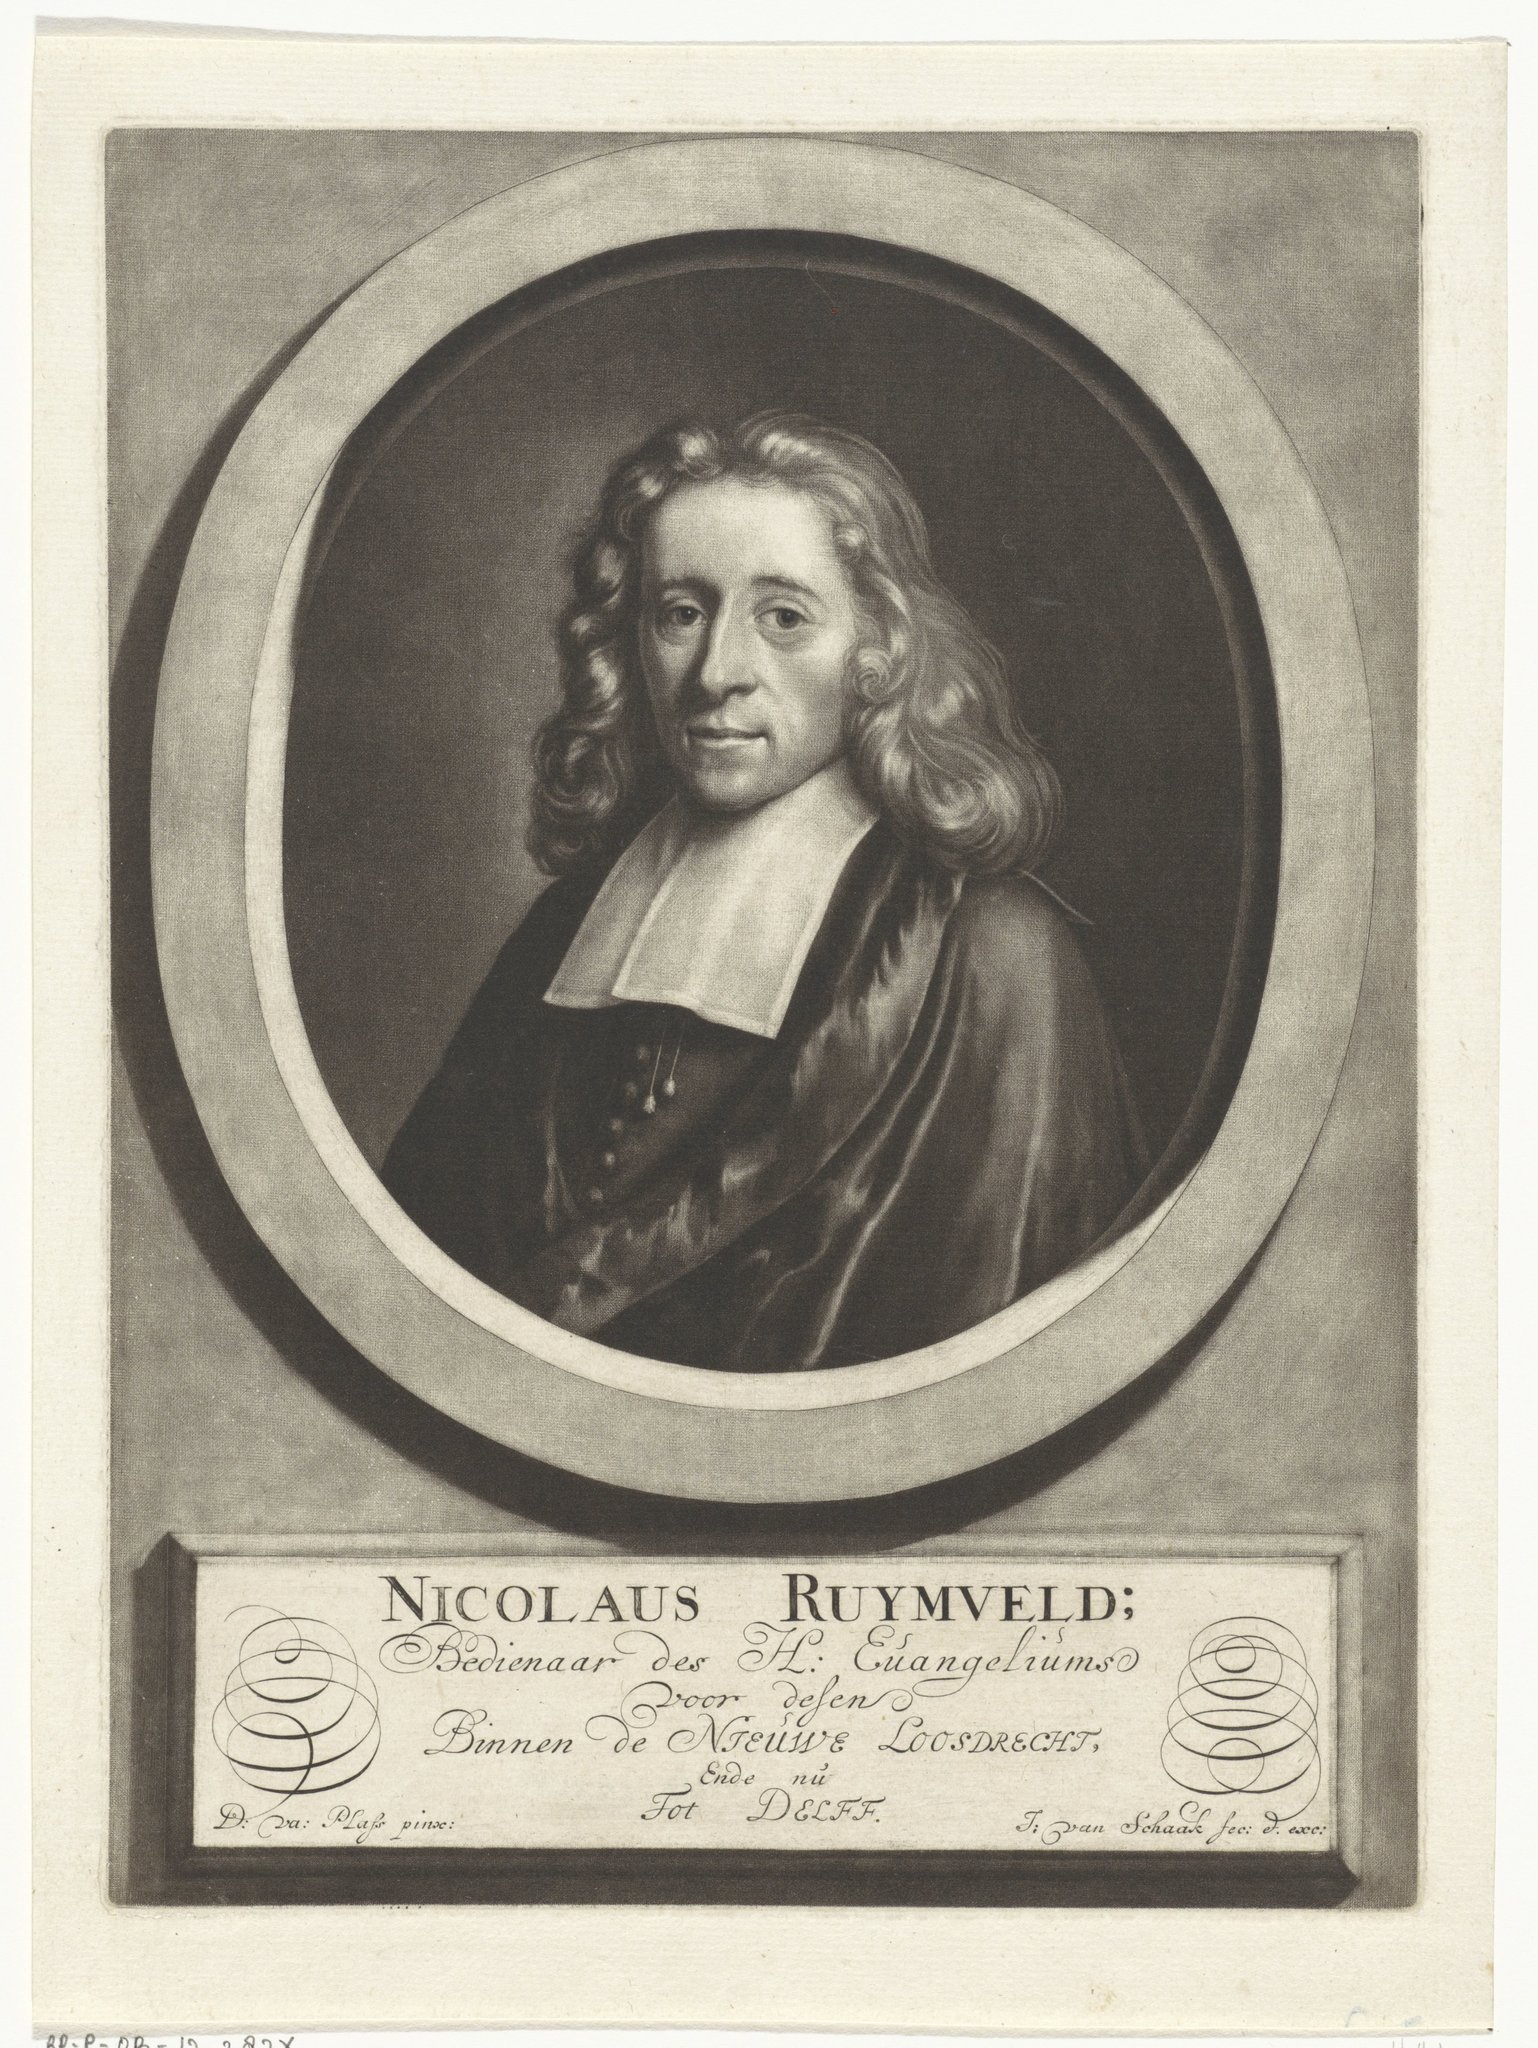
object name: print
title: Portret van de predikant Nicolaus Ruymvelt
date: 1690-1727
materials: paper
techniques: engraving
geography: delft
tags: predikant, nicolaus ruymvelt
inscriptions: collector's mark: Lugt 2228